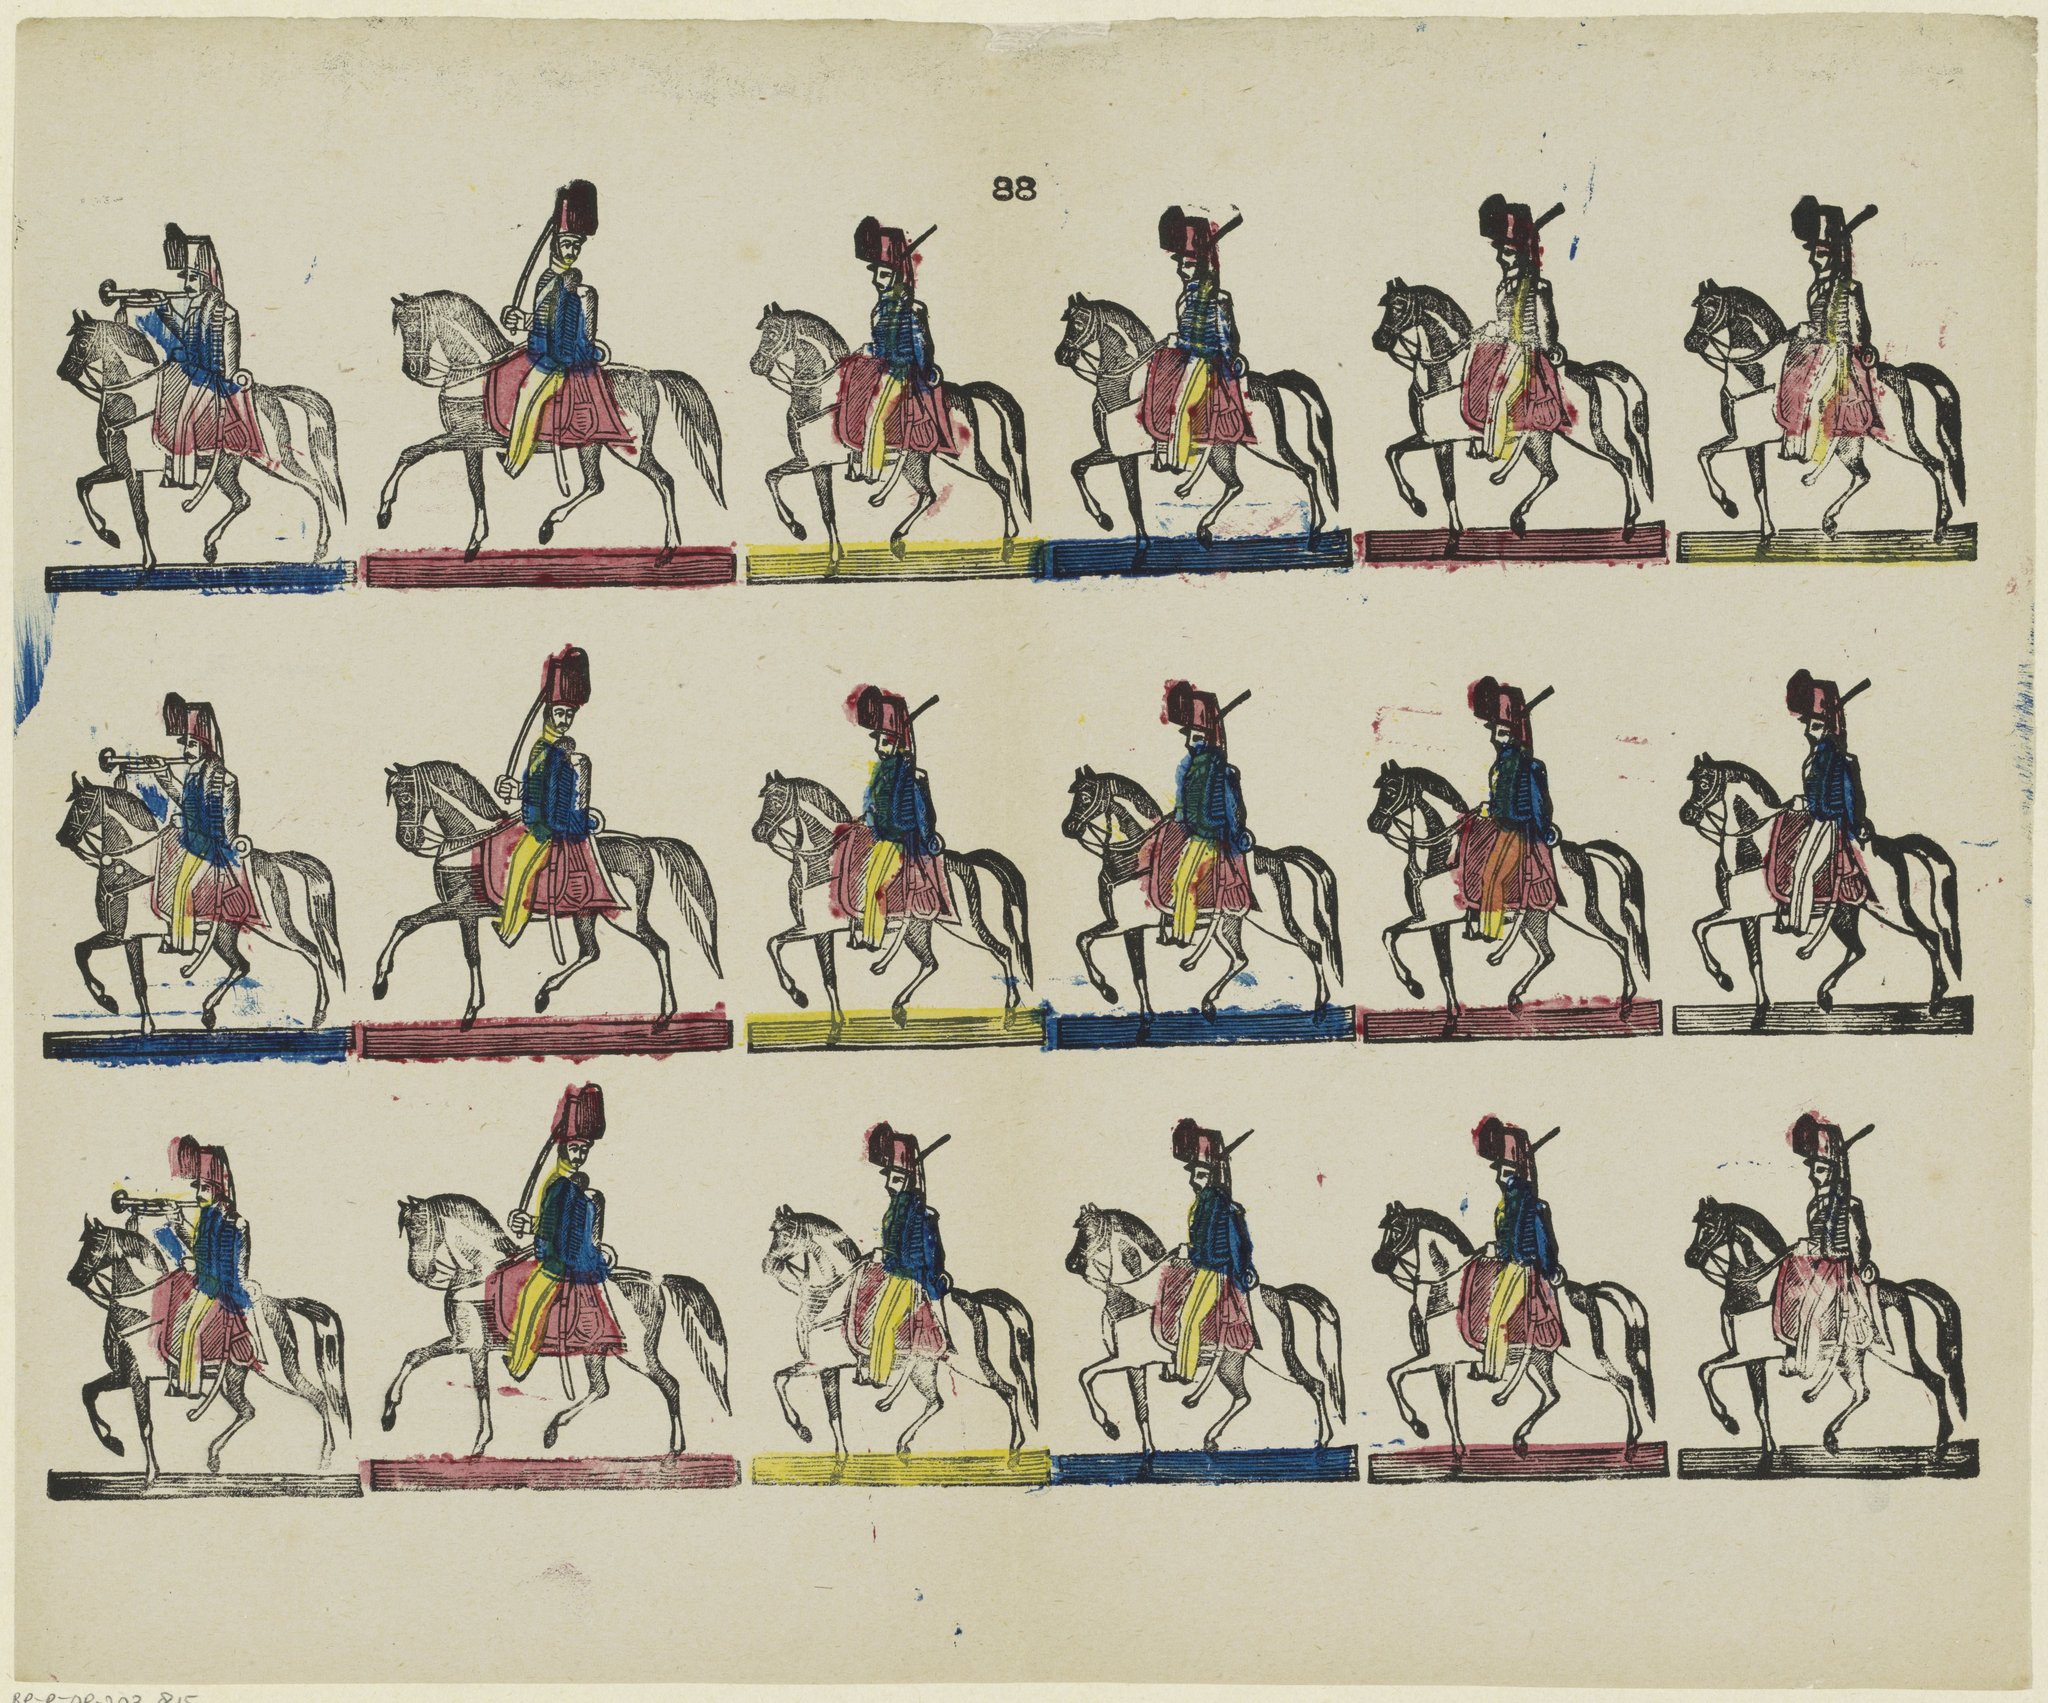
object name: popular print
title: Militairen te paard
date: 1827-1894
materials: paper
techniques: colour, letterpress printing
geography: schaarbeek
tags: warfare; military affairs (+ cavalry, horsemen), the soldier; the soldier's life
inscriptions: collector's mark: Lugt 2760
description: Blad met 18 voorstellingen van militairen te paard. Genummerd midden boven: 88.